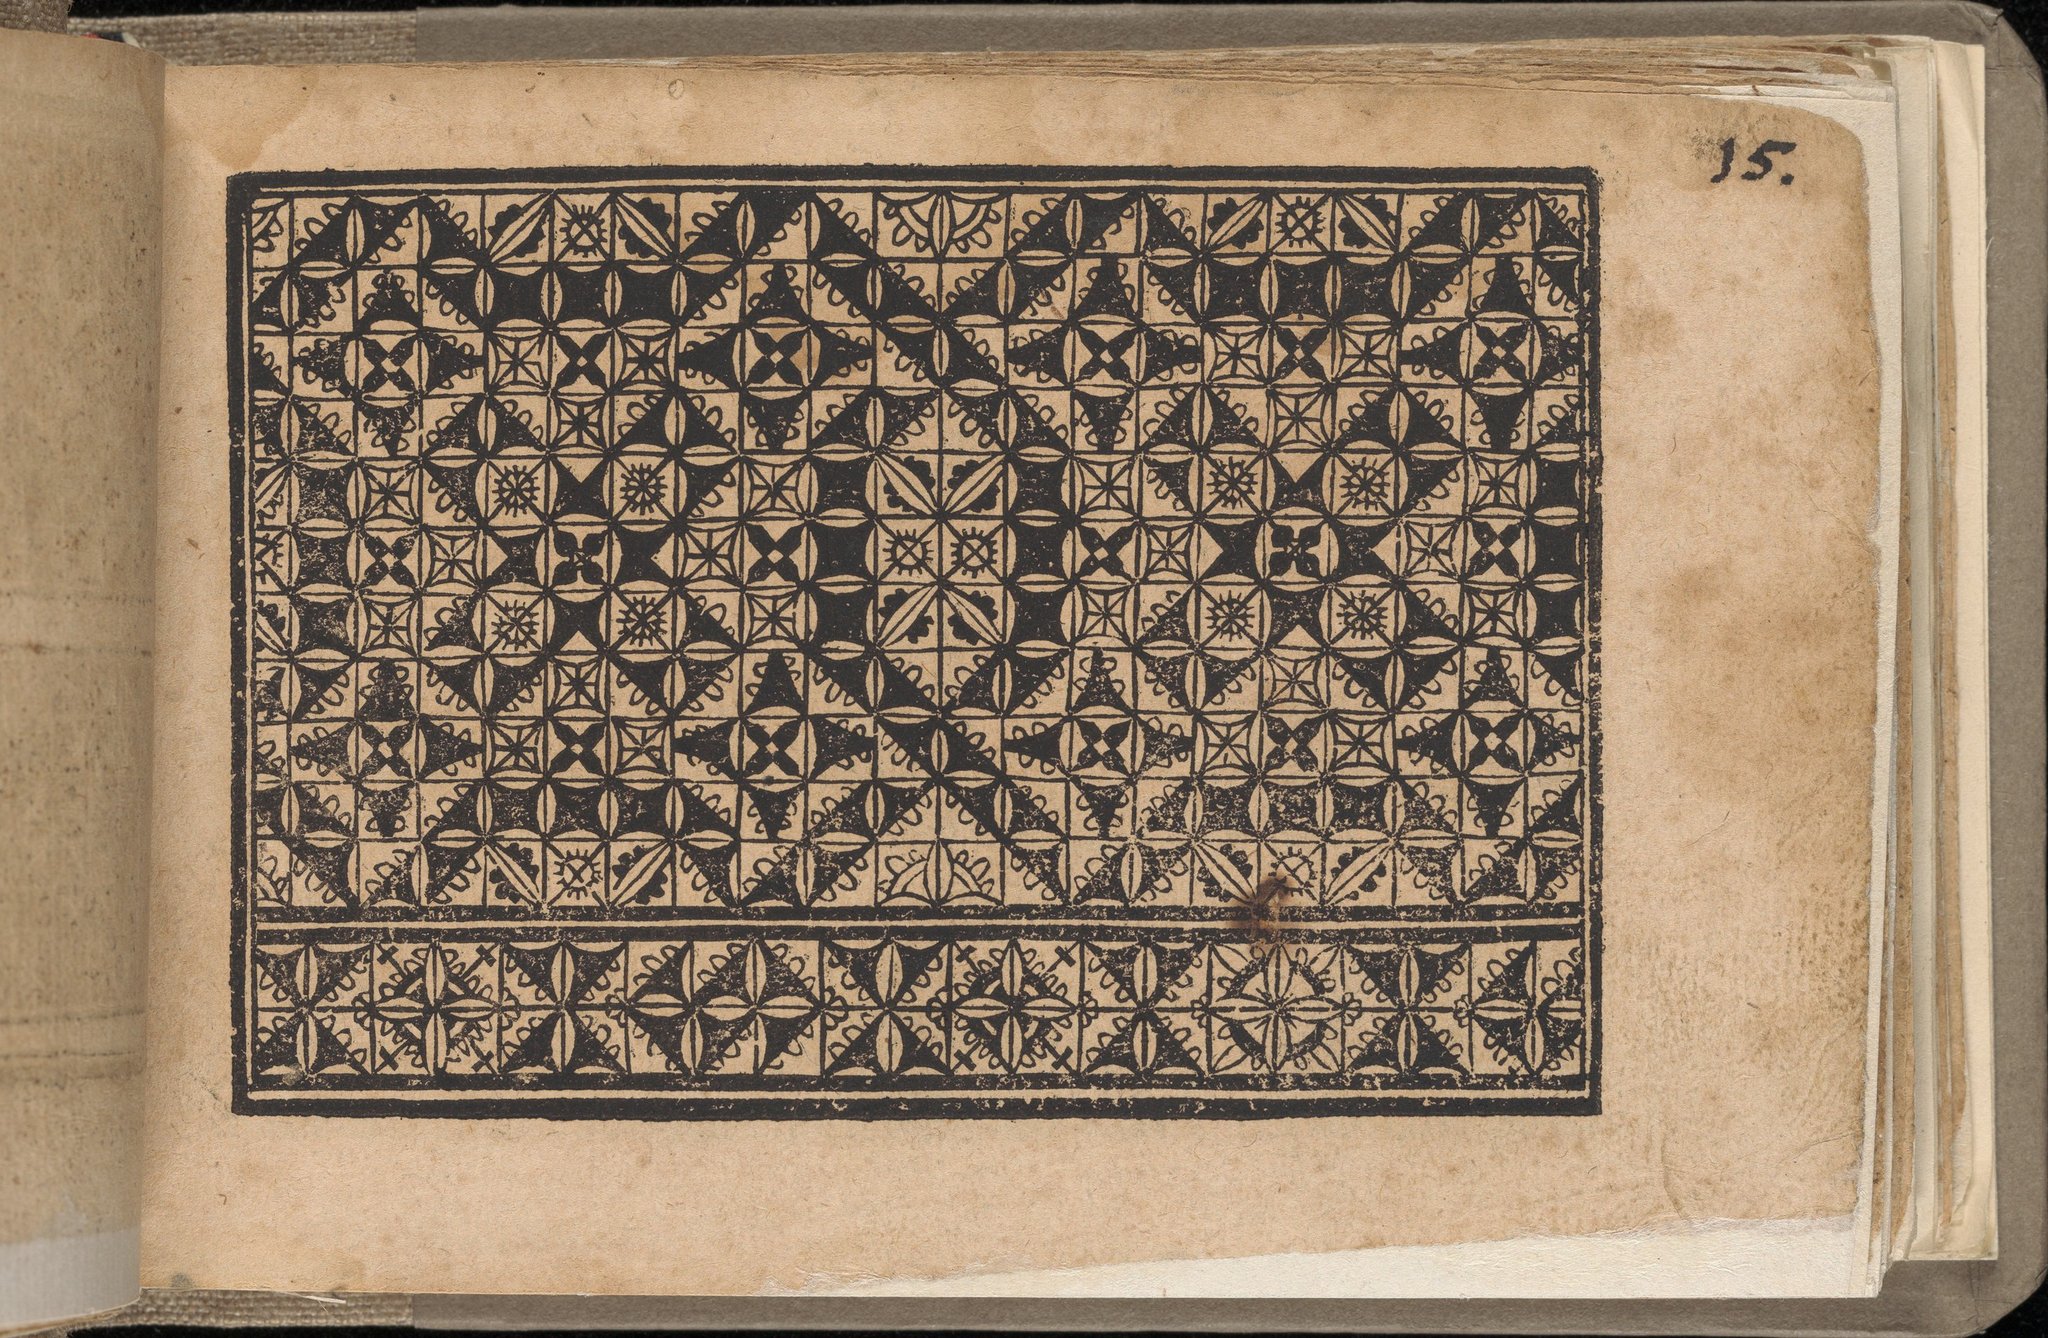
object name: book print ornament architecture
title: Schön newes Modelbuch (Page 15r)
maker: sigismundus latomus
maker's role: publisher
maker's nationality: german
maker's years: 1599-1632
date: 1608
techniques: woodcut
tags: ornament